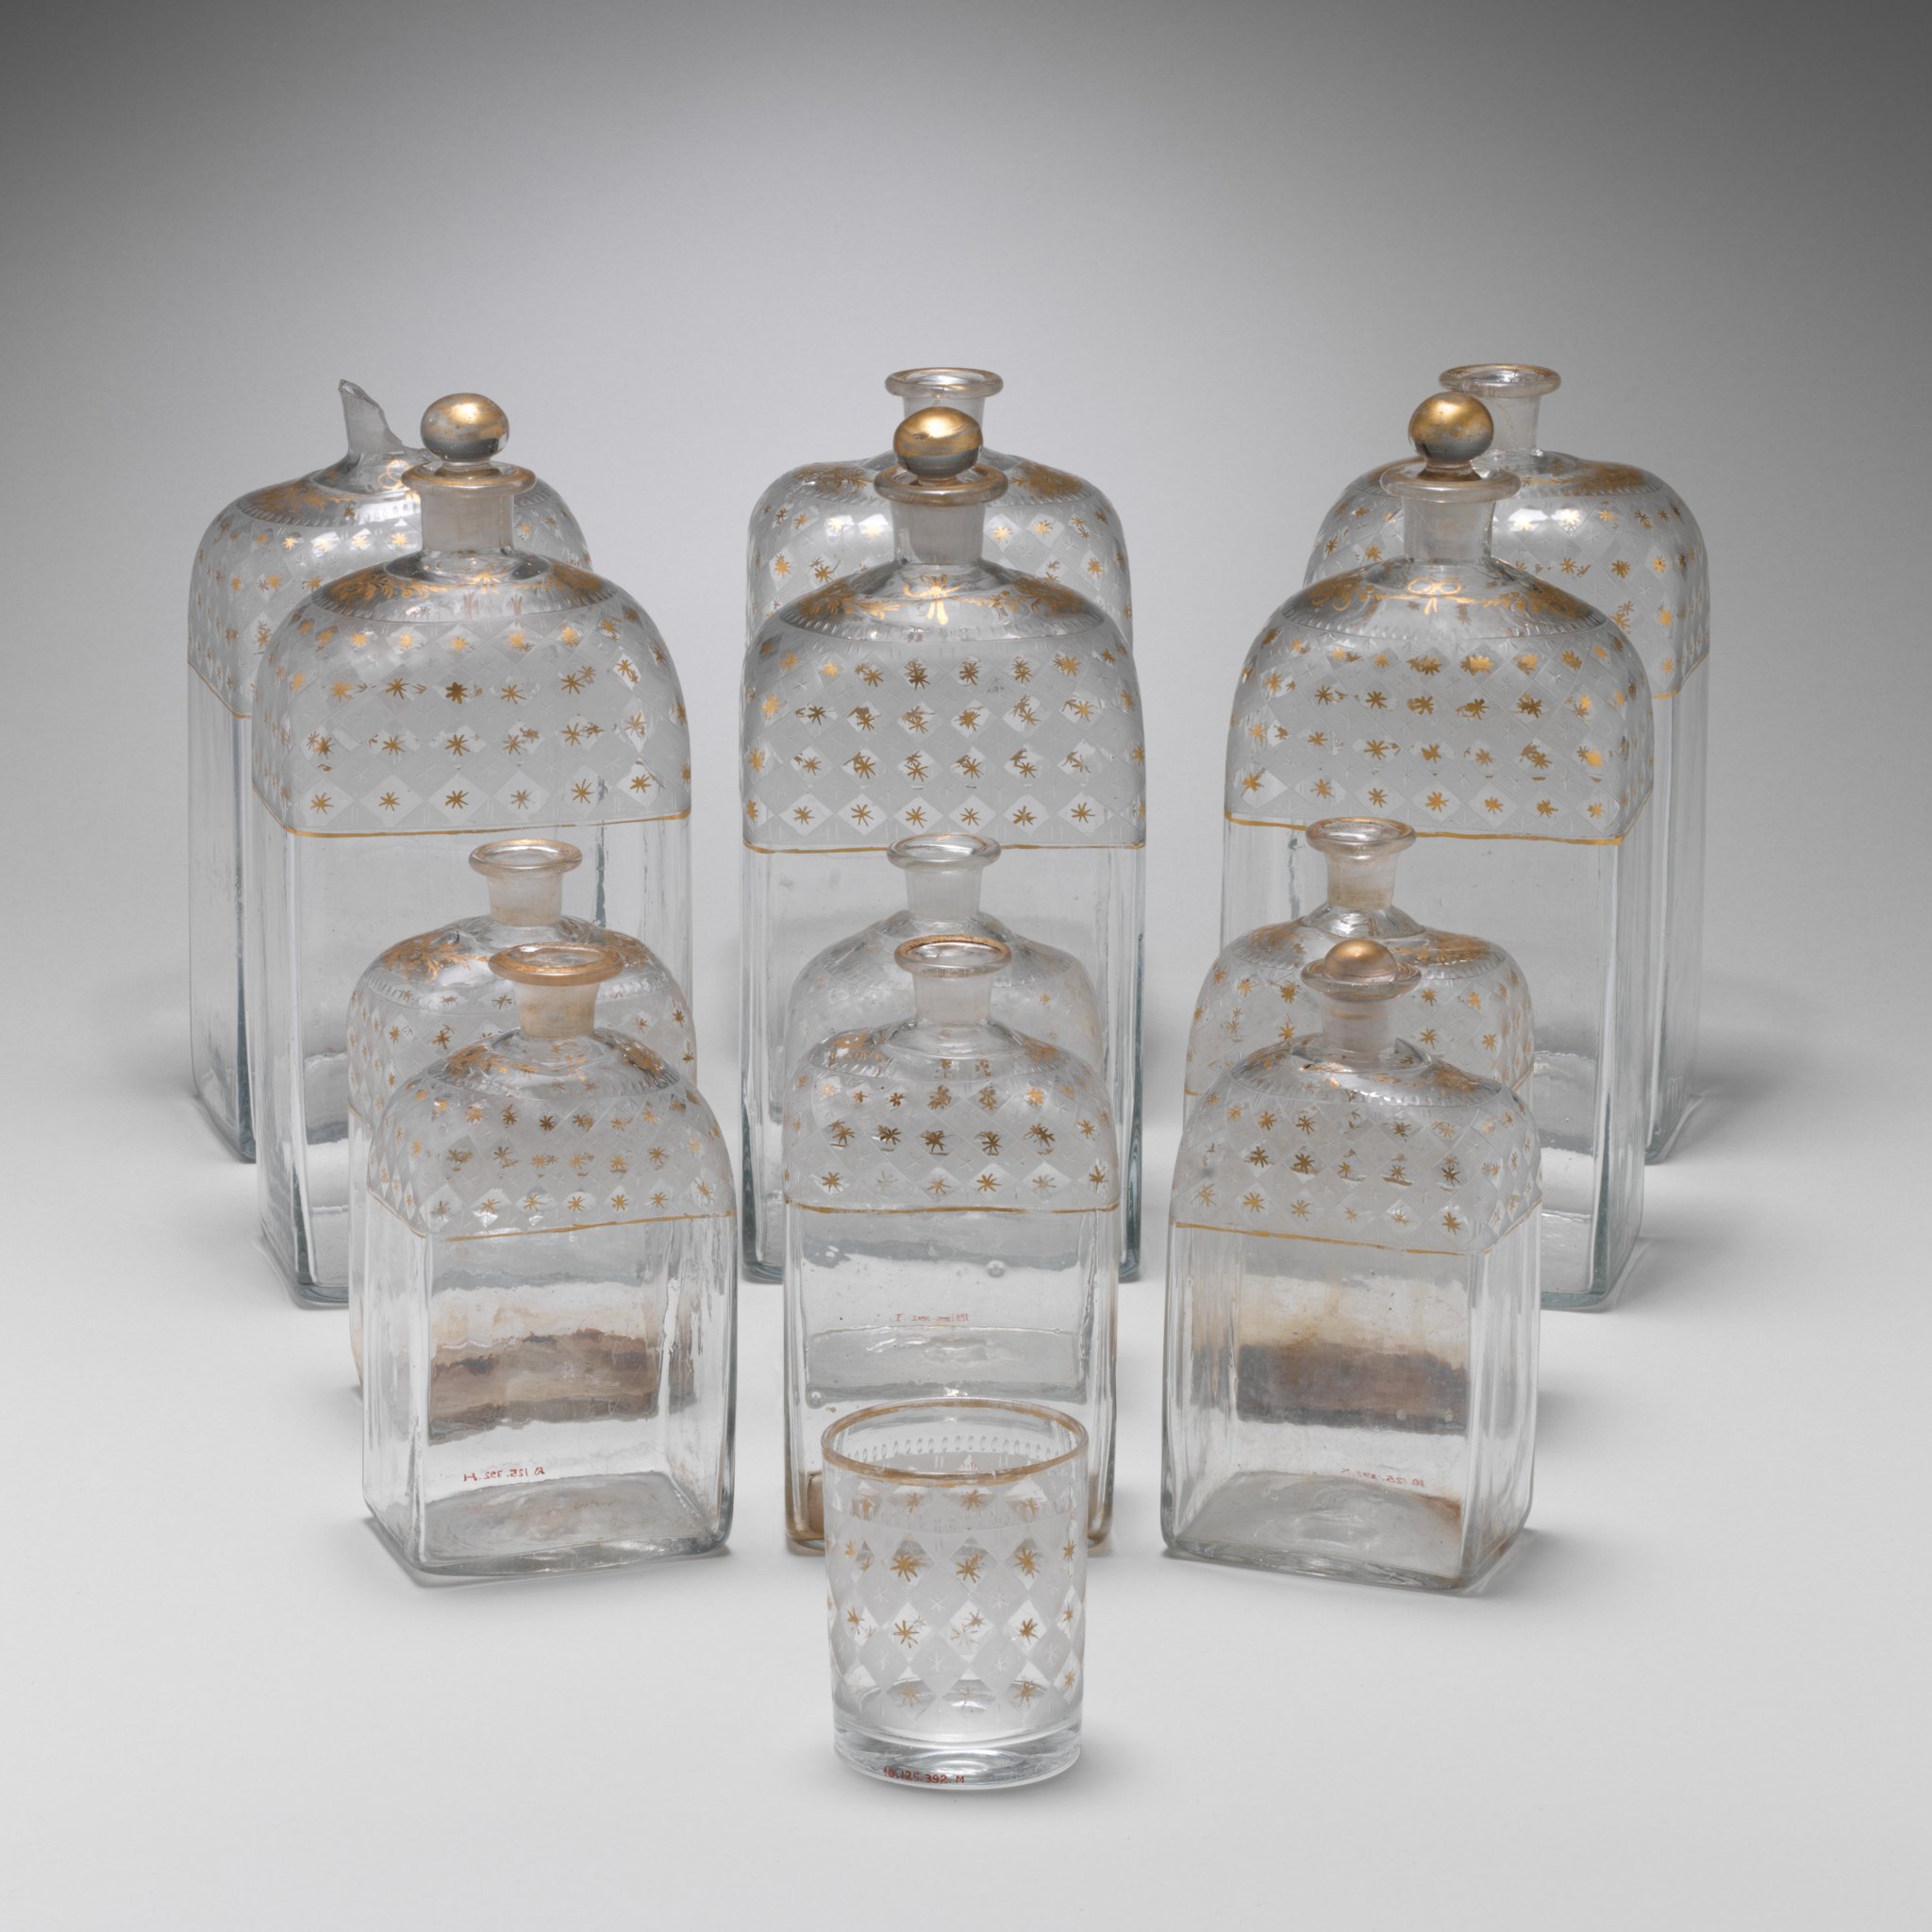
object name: canteen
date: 1750-1800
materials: glass, iron, wood